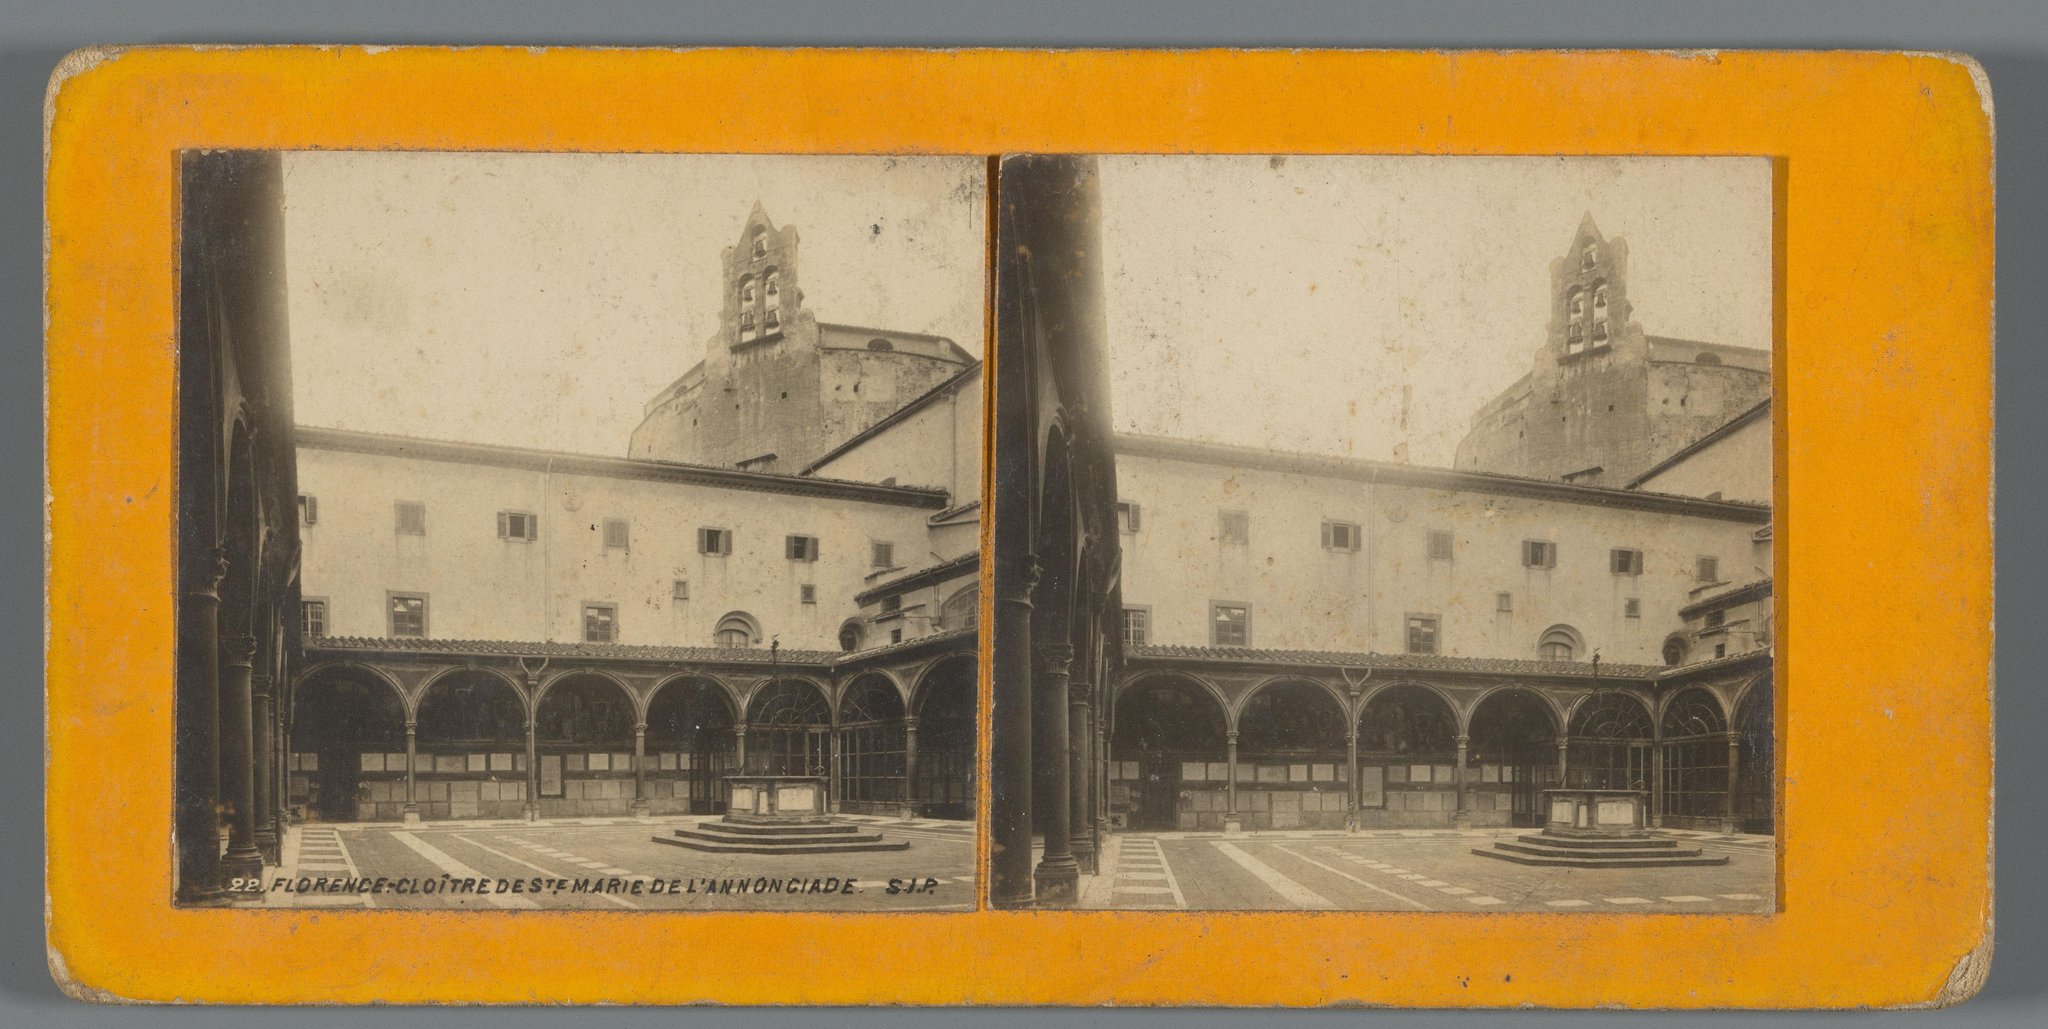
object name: stereograph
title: Binnenplaats van een klooster in Florence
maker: Anonymous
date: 1890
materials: paper, cardboard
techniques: gelatin silver print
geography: florence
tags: cloisters ~ monastery, courtyard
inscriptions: number: ‘22.’